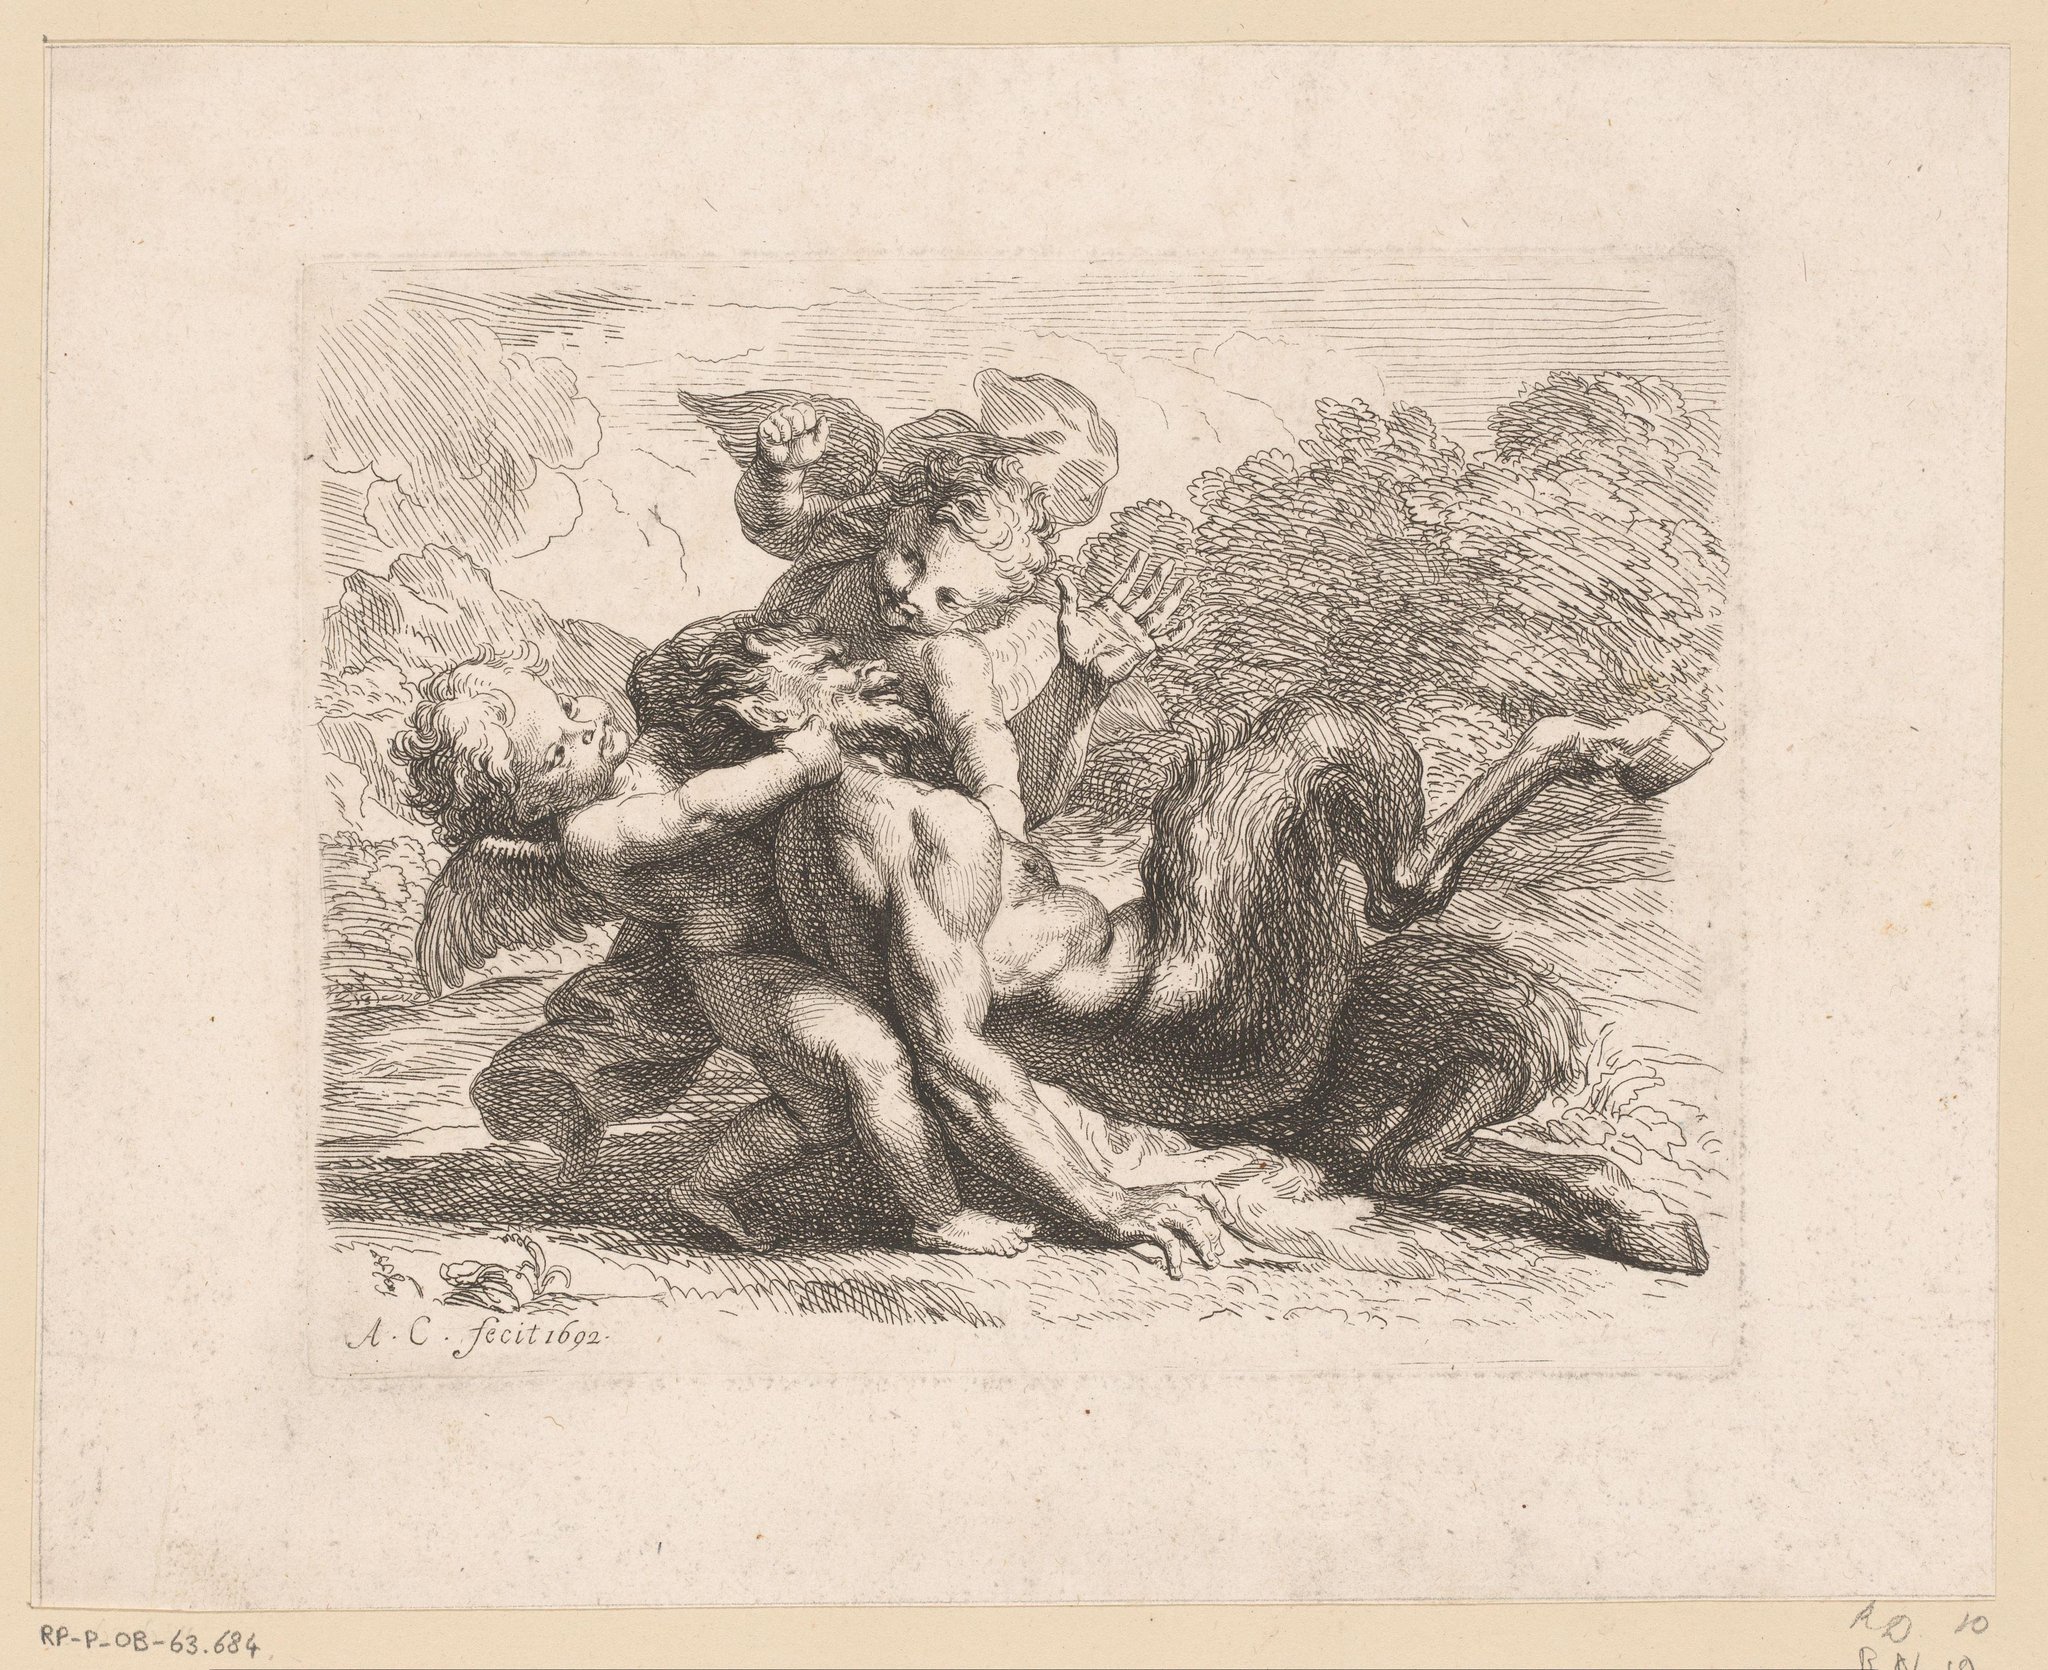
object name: print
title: Pan overwonnen door amors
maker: antoine coypel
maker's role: draughtsman, print maker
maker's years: 1661-1722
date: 1692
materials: paper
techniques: etching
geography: france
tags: cupid vanquishing pan, cupids: 'amores', 'amoretti', 'putti'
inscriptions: collector's mark: Lugt 240